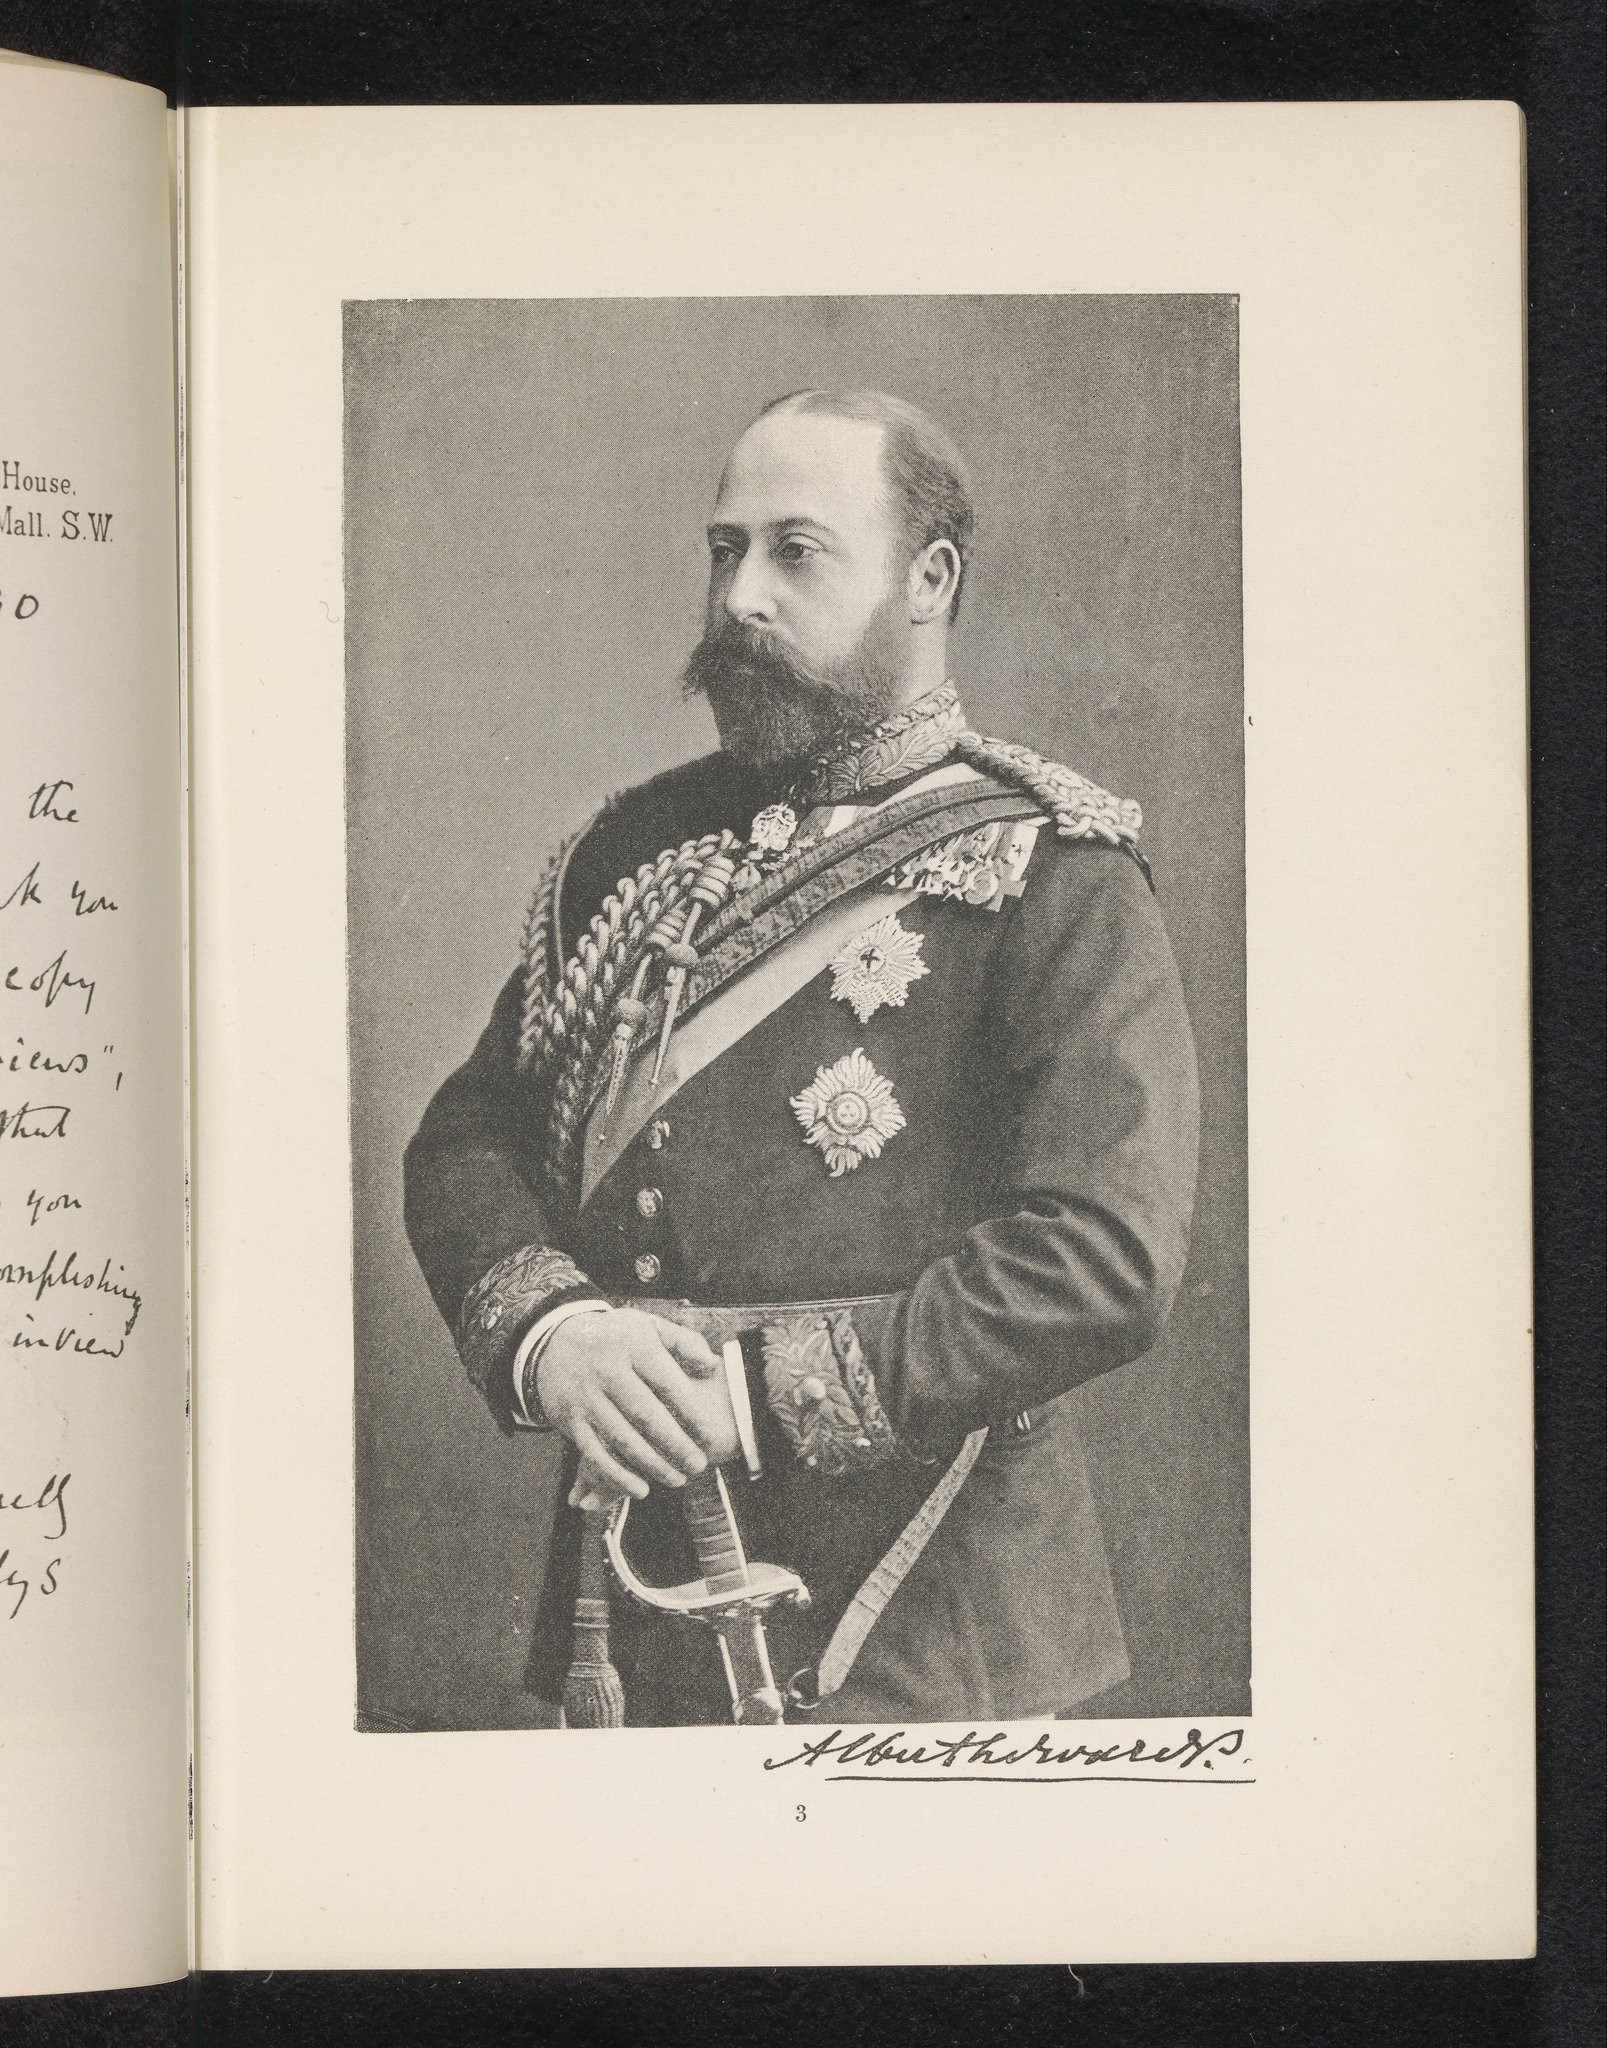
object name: photomechanical print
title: Portret van prins Eduard VII van het Verenigd Koninkrijk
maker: Anonymous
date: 1881-1891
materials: paper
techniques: autotype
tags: ruler, sovereign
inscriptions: inscription